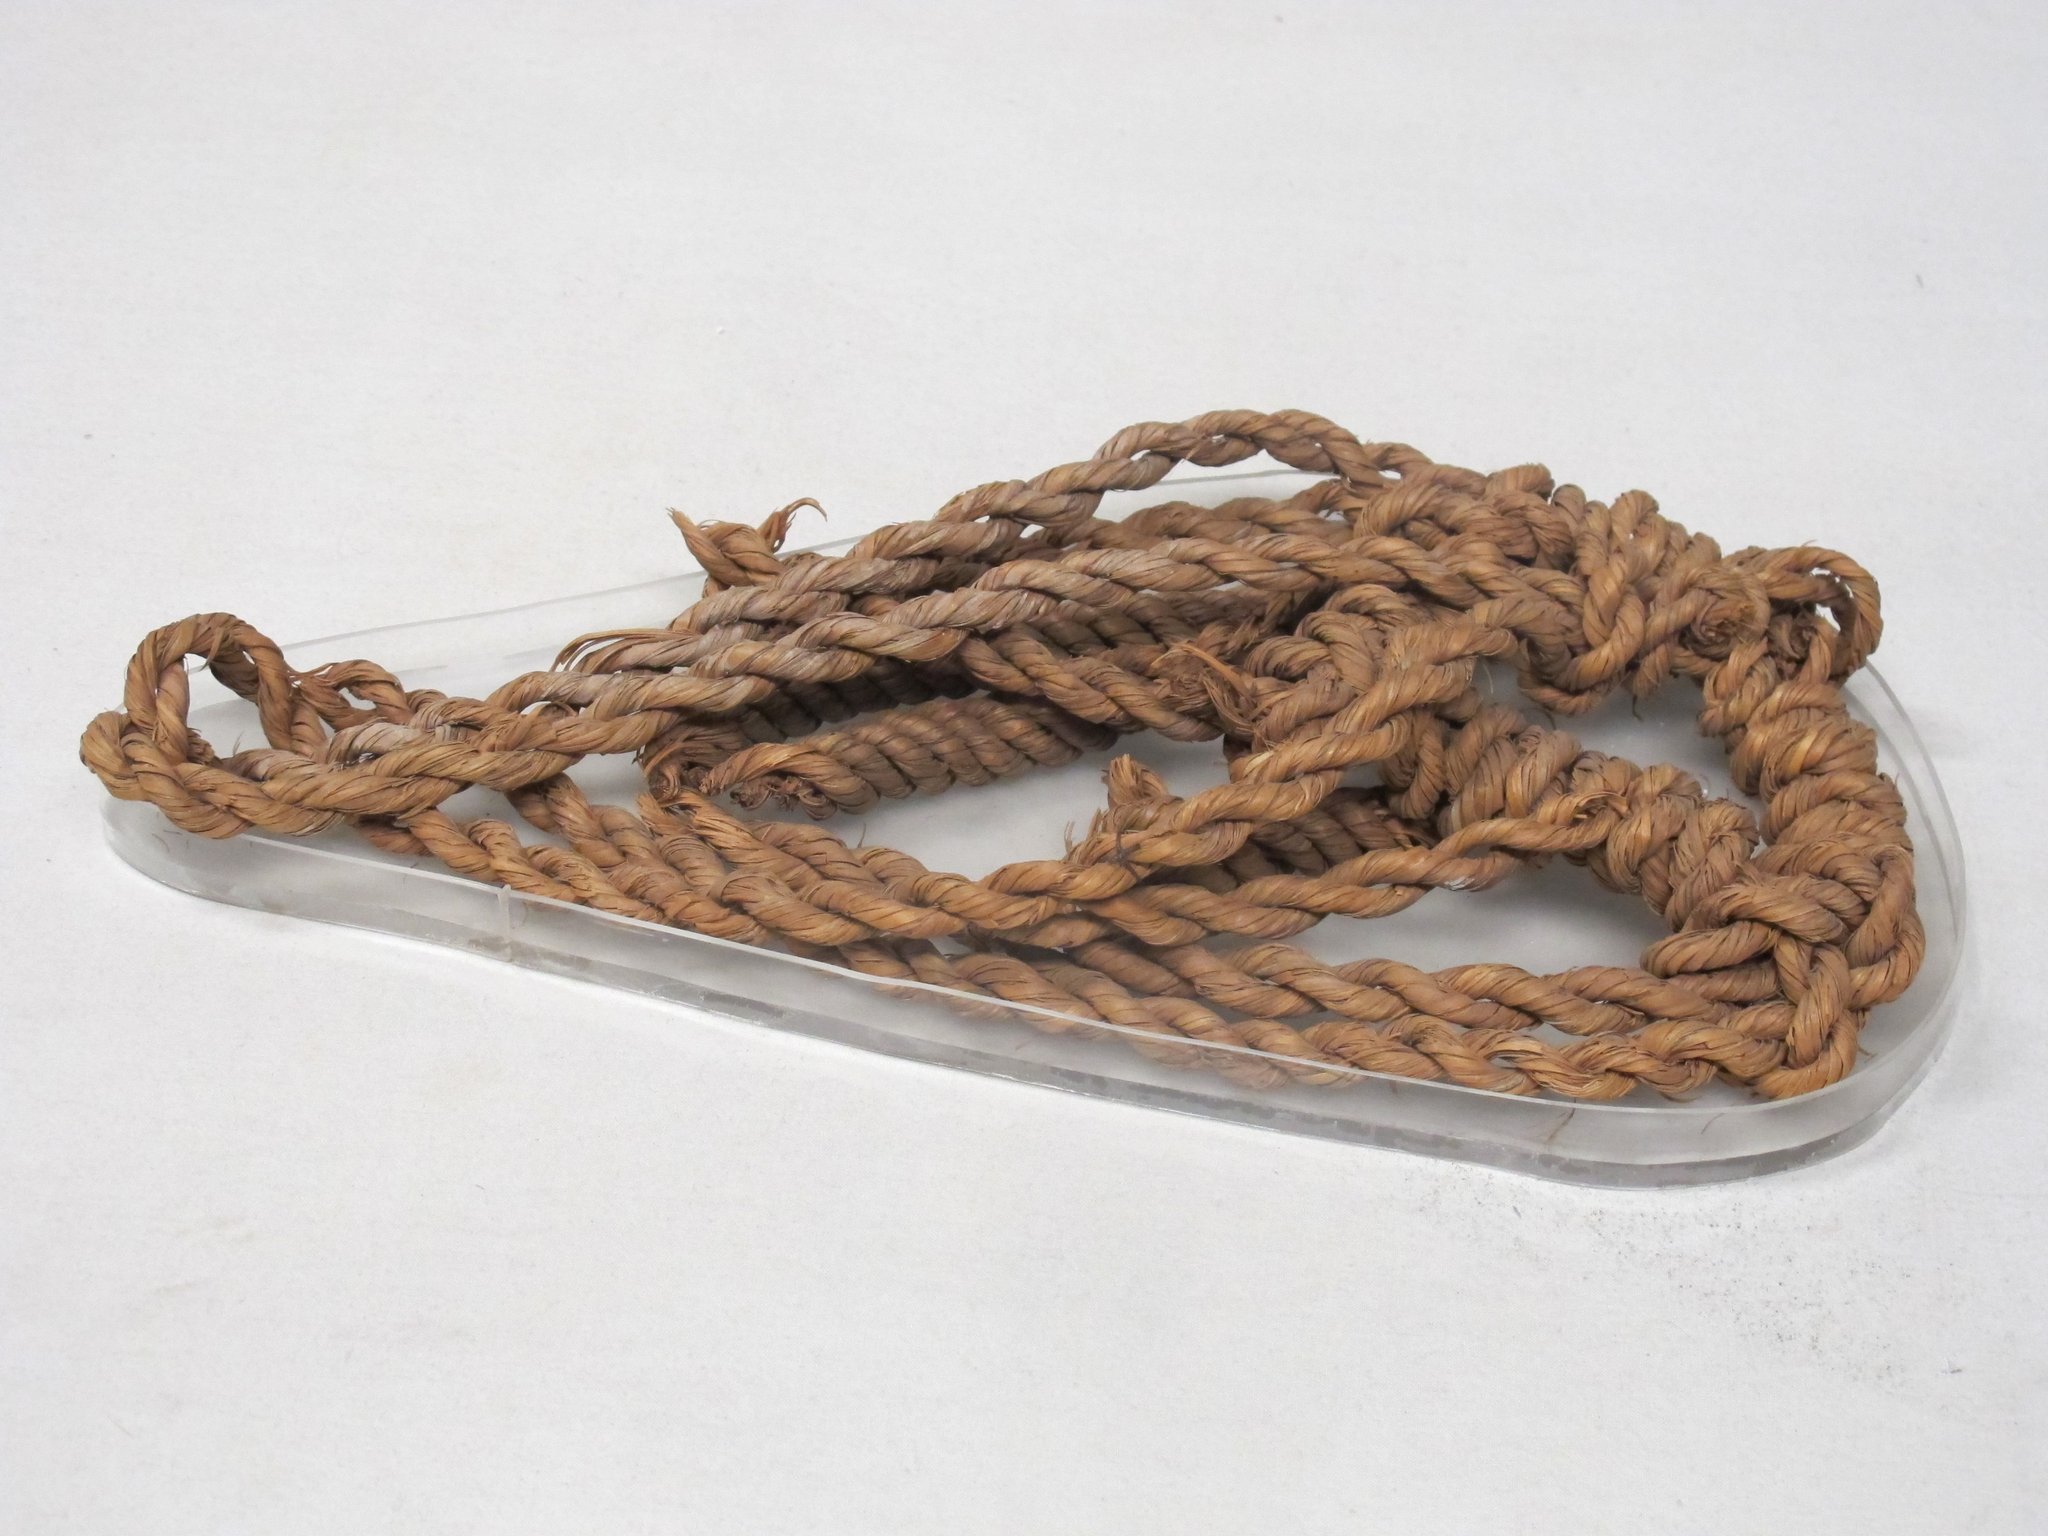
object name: rope jar sling, ipy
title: Rope Jar Sling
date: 2030-1640 BCE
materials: fiber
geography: egypt